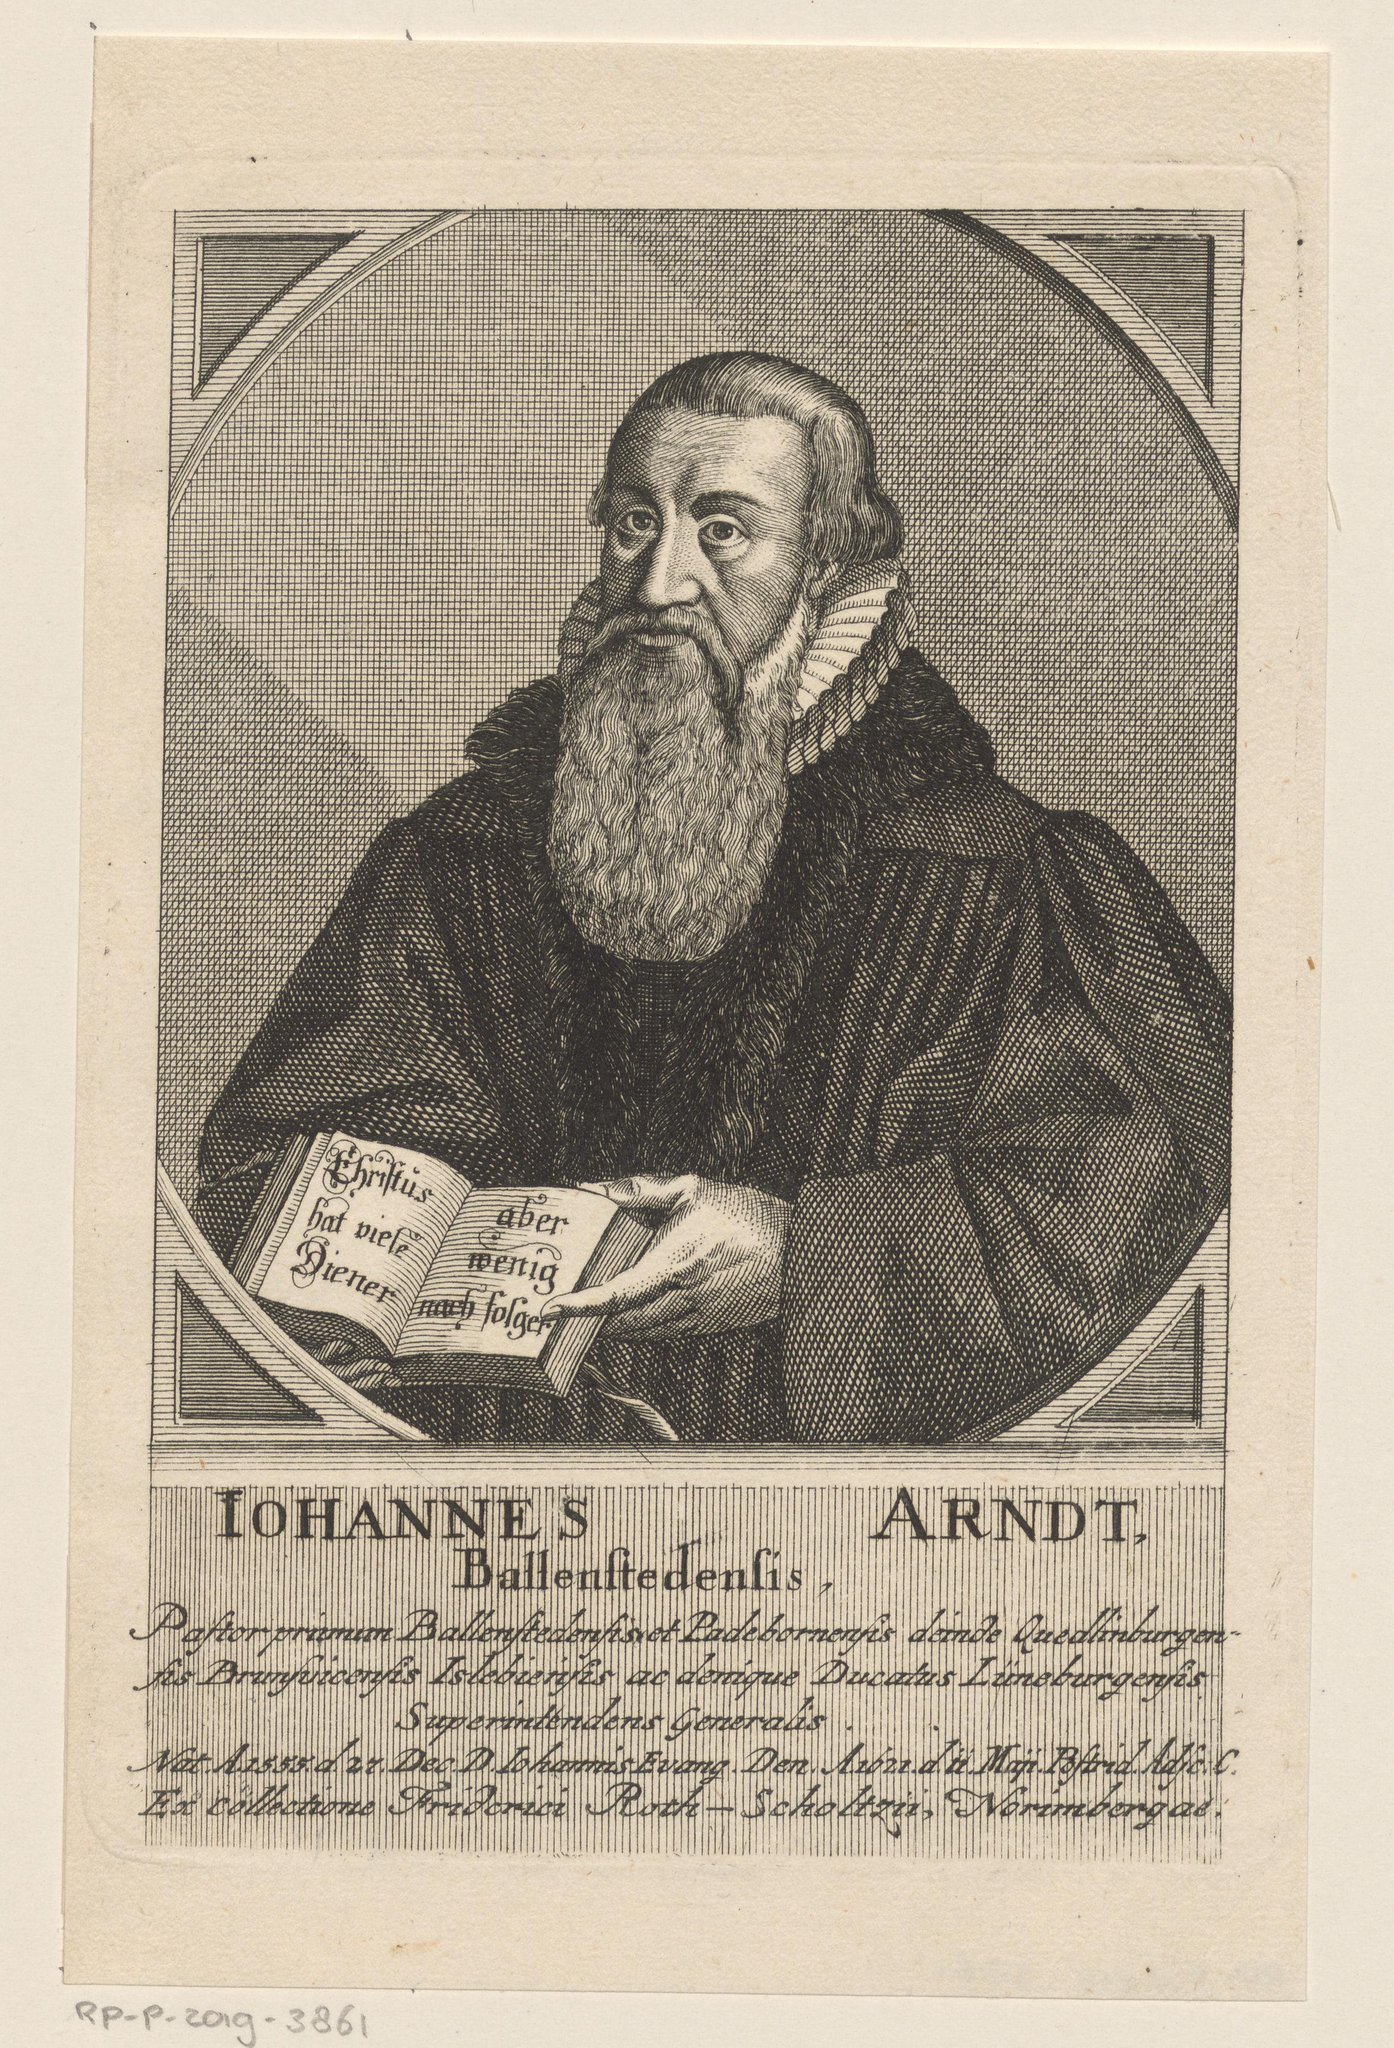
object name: print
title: Portret van Johann Arndt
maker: Anonymous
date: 1650-1749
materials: paper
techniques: engraving, etching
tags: theologian, historical persons, book